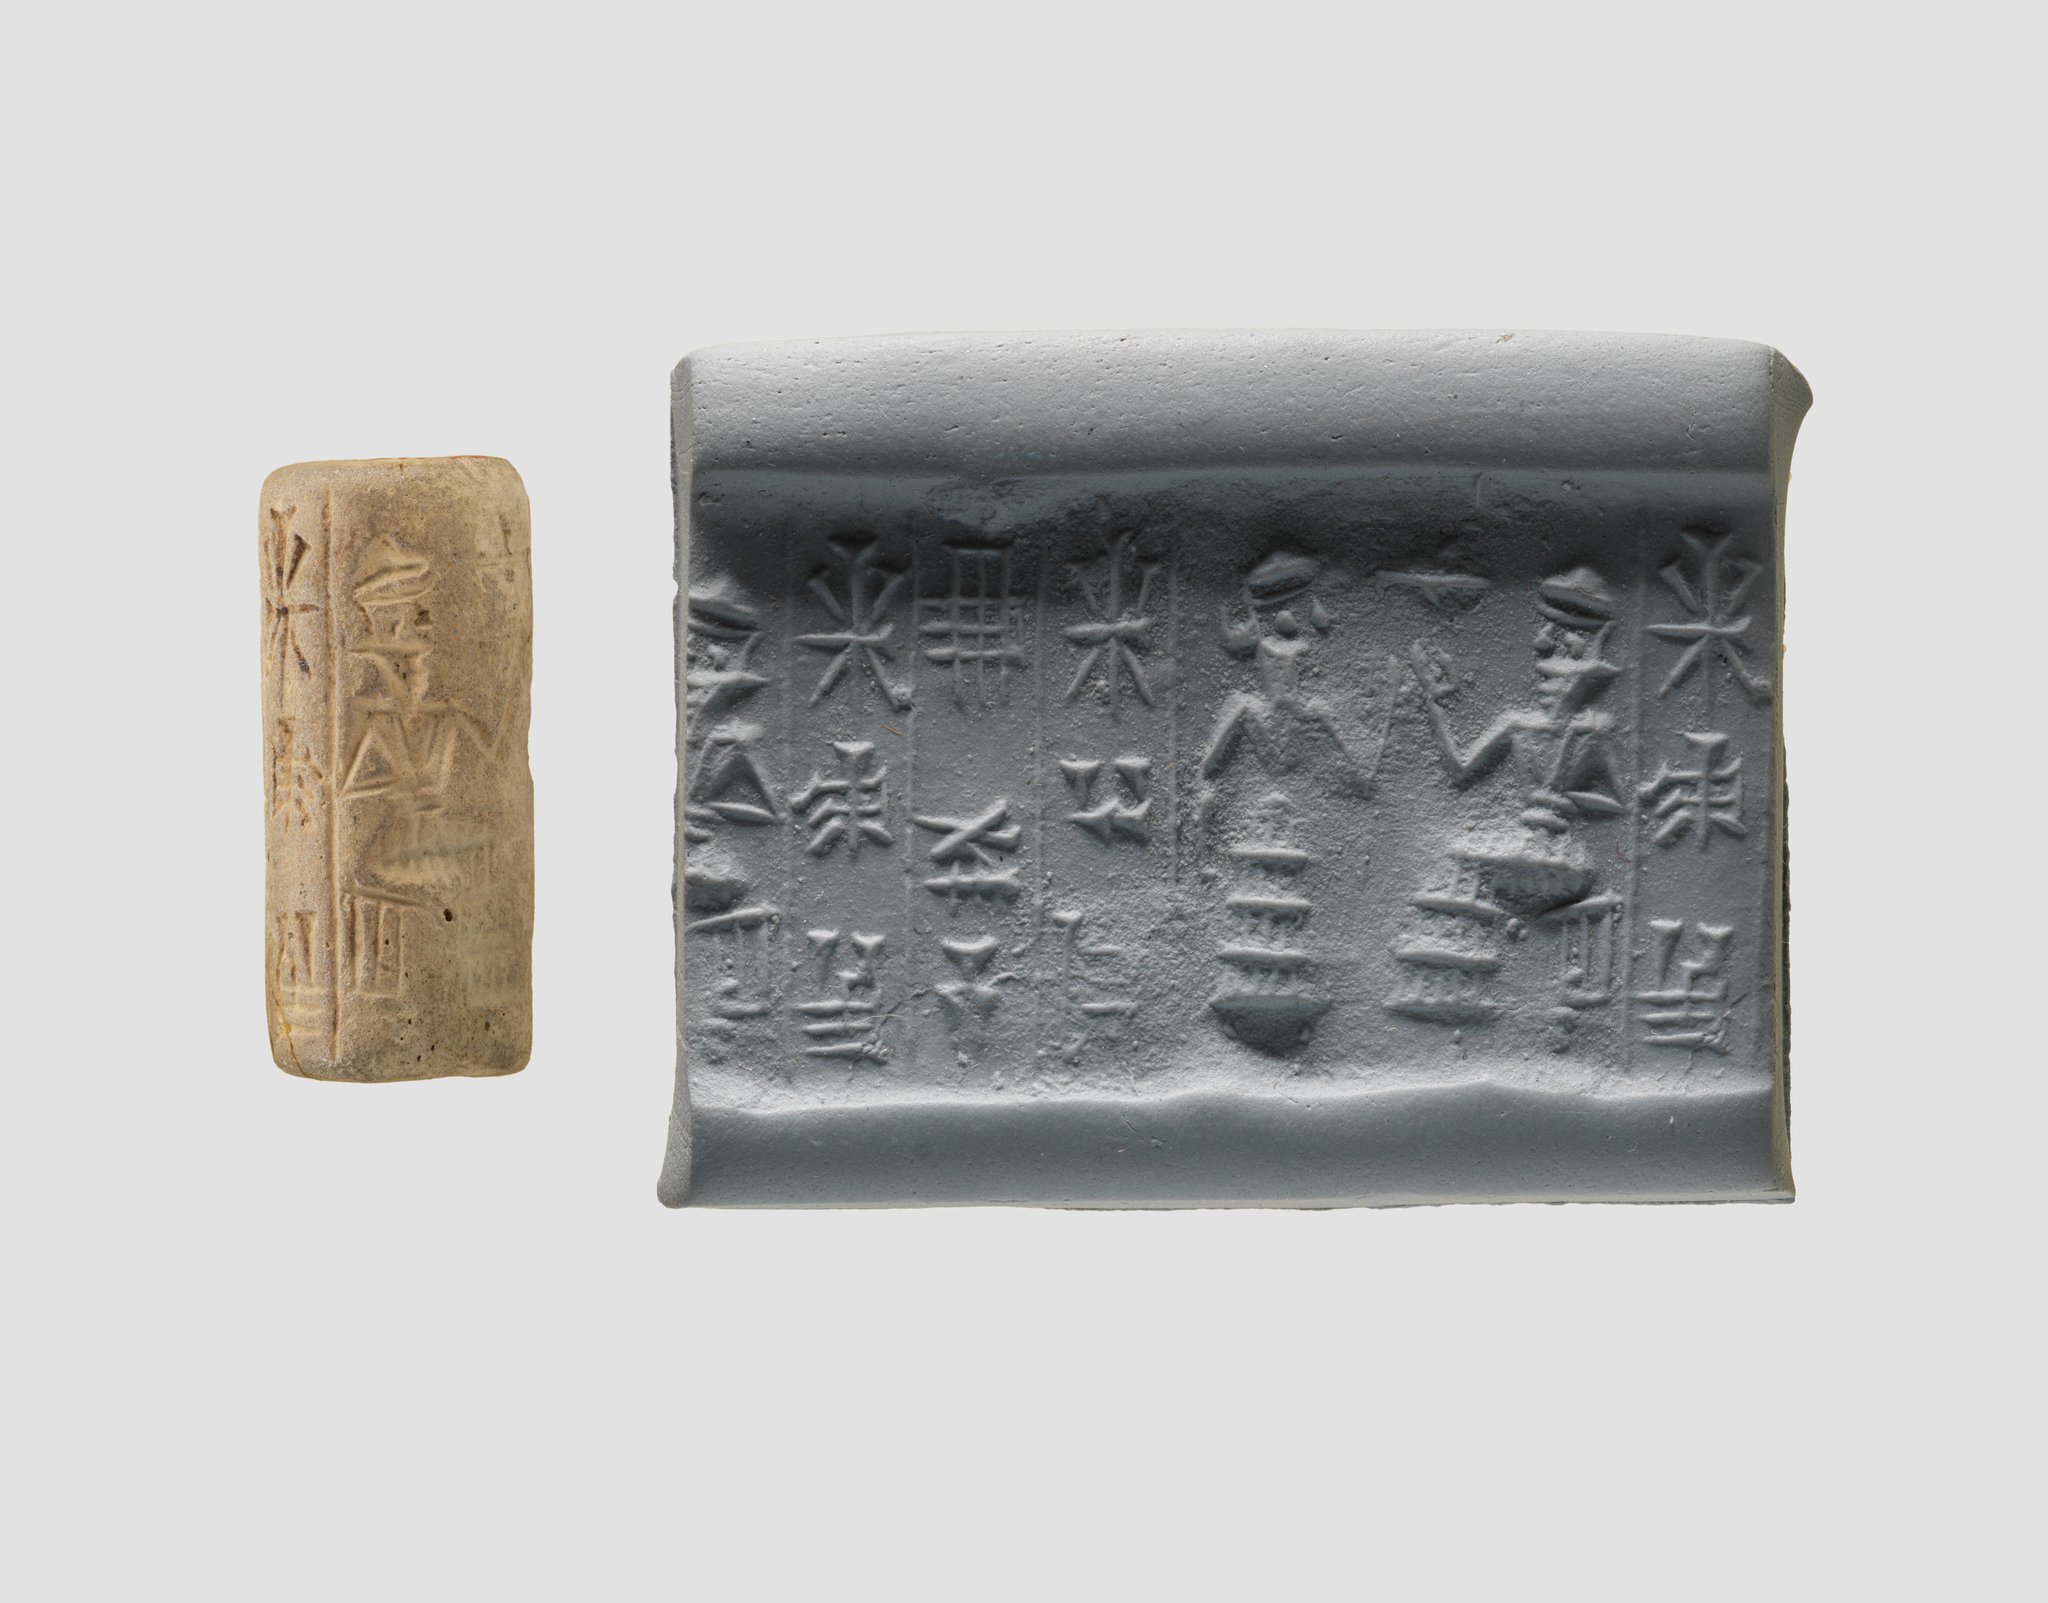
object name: cylinder seal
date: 1500-1301 BCE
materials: faience